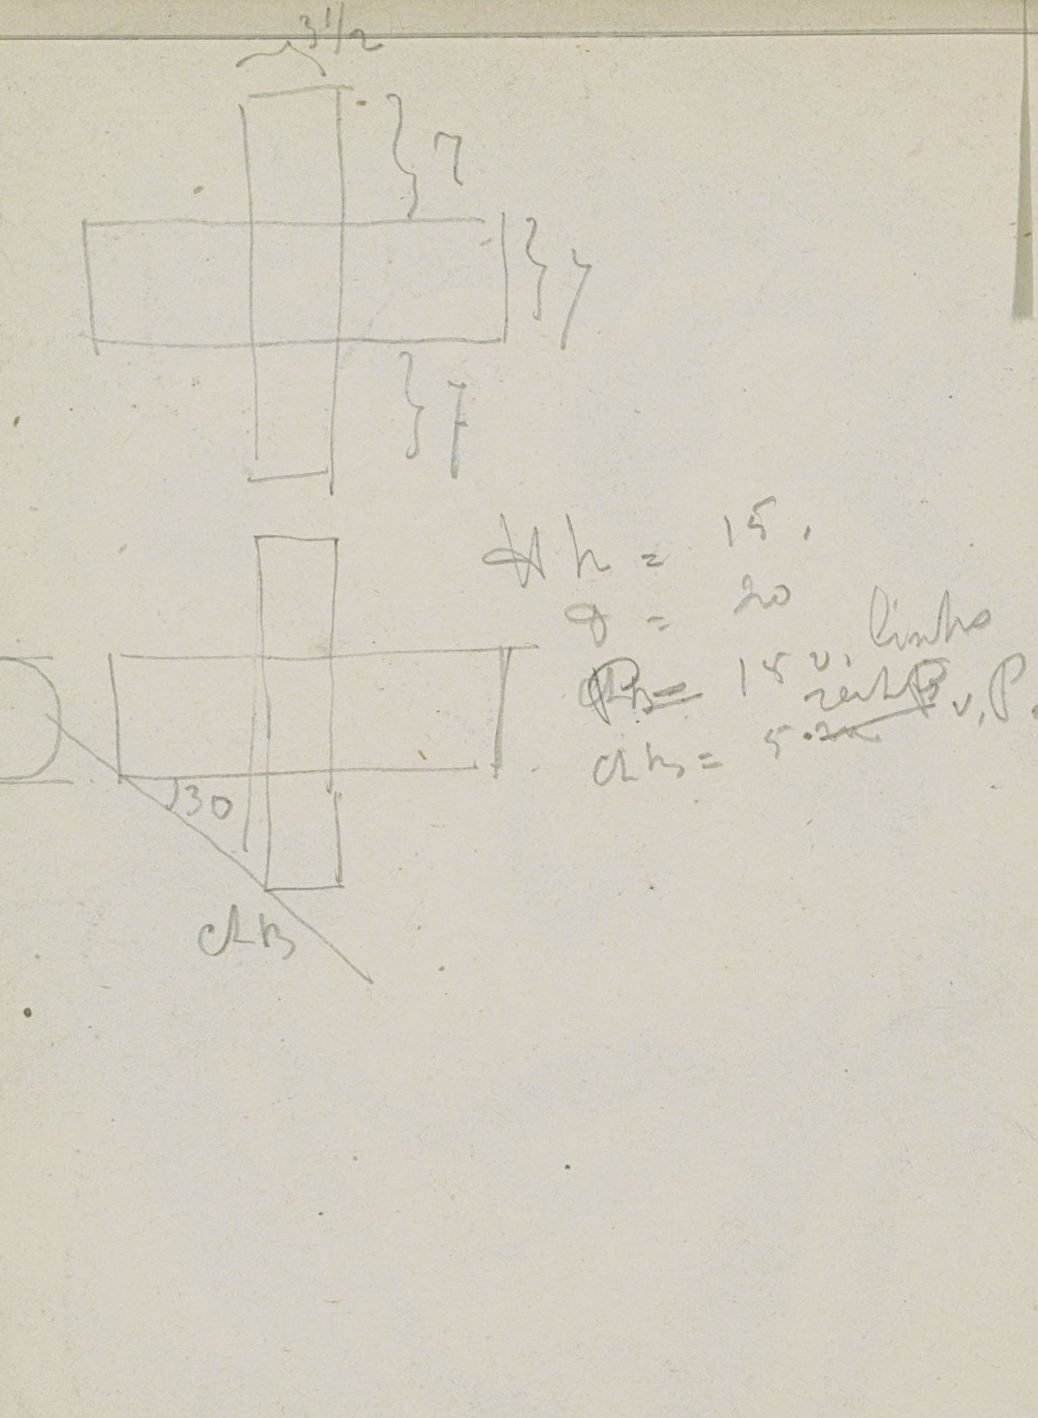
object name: sketchbook leaf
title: Plattegrond of model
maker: reijer stolk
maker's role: draughtsman, print maker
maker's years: 1896-1945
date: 1906-1945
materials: paper, pencil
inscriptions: annotation: ‘[...]’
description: Blad 6 verso uit een schetsboek met 53 bladen.